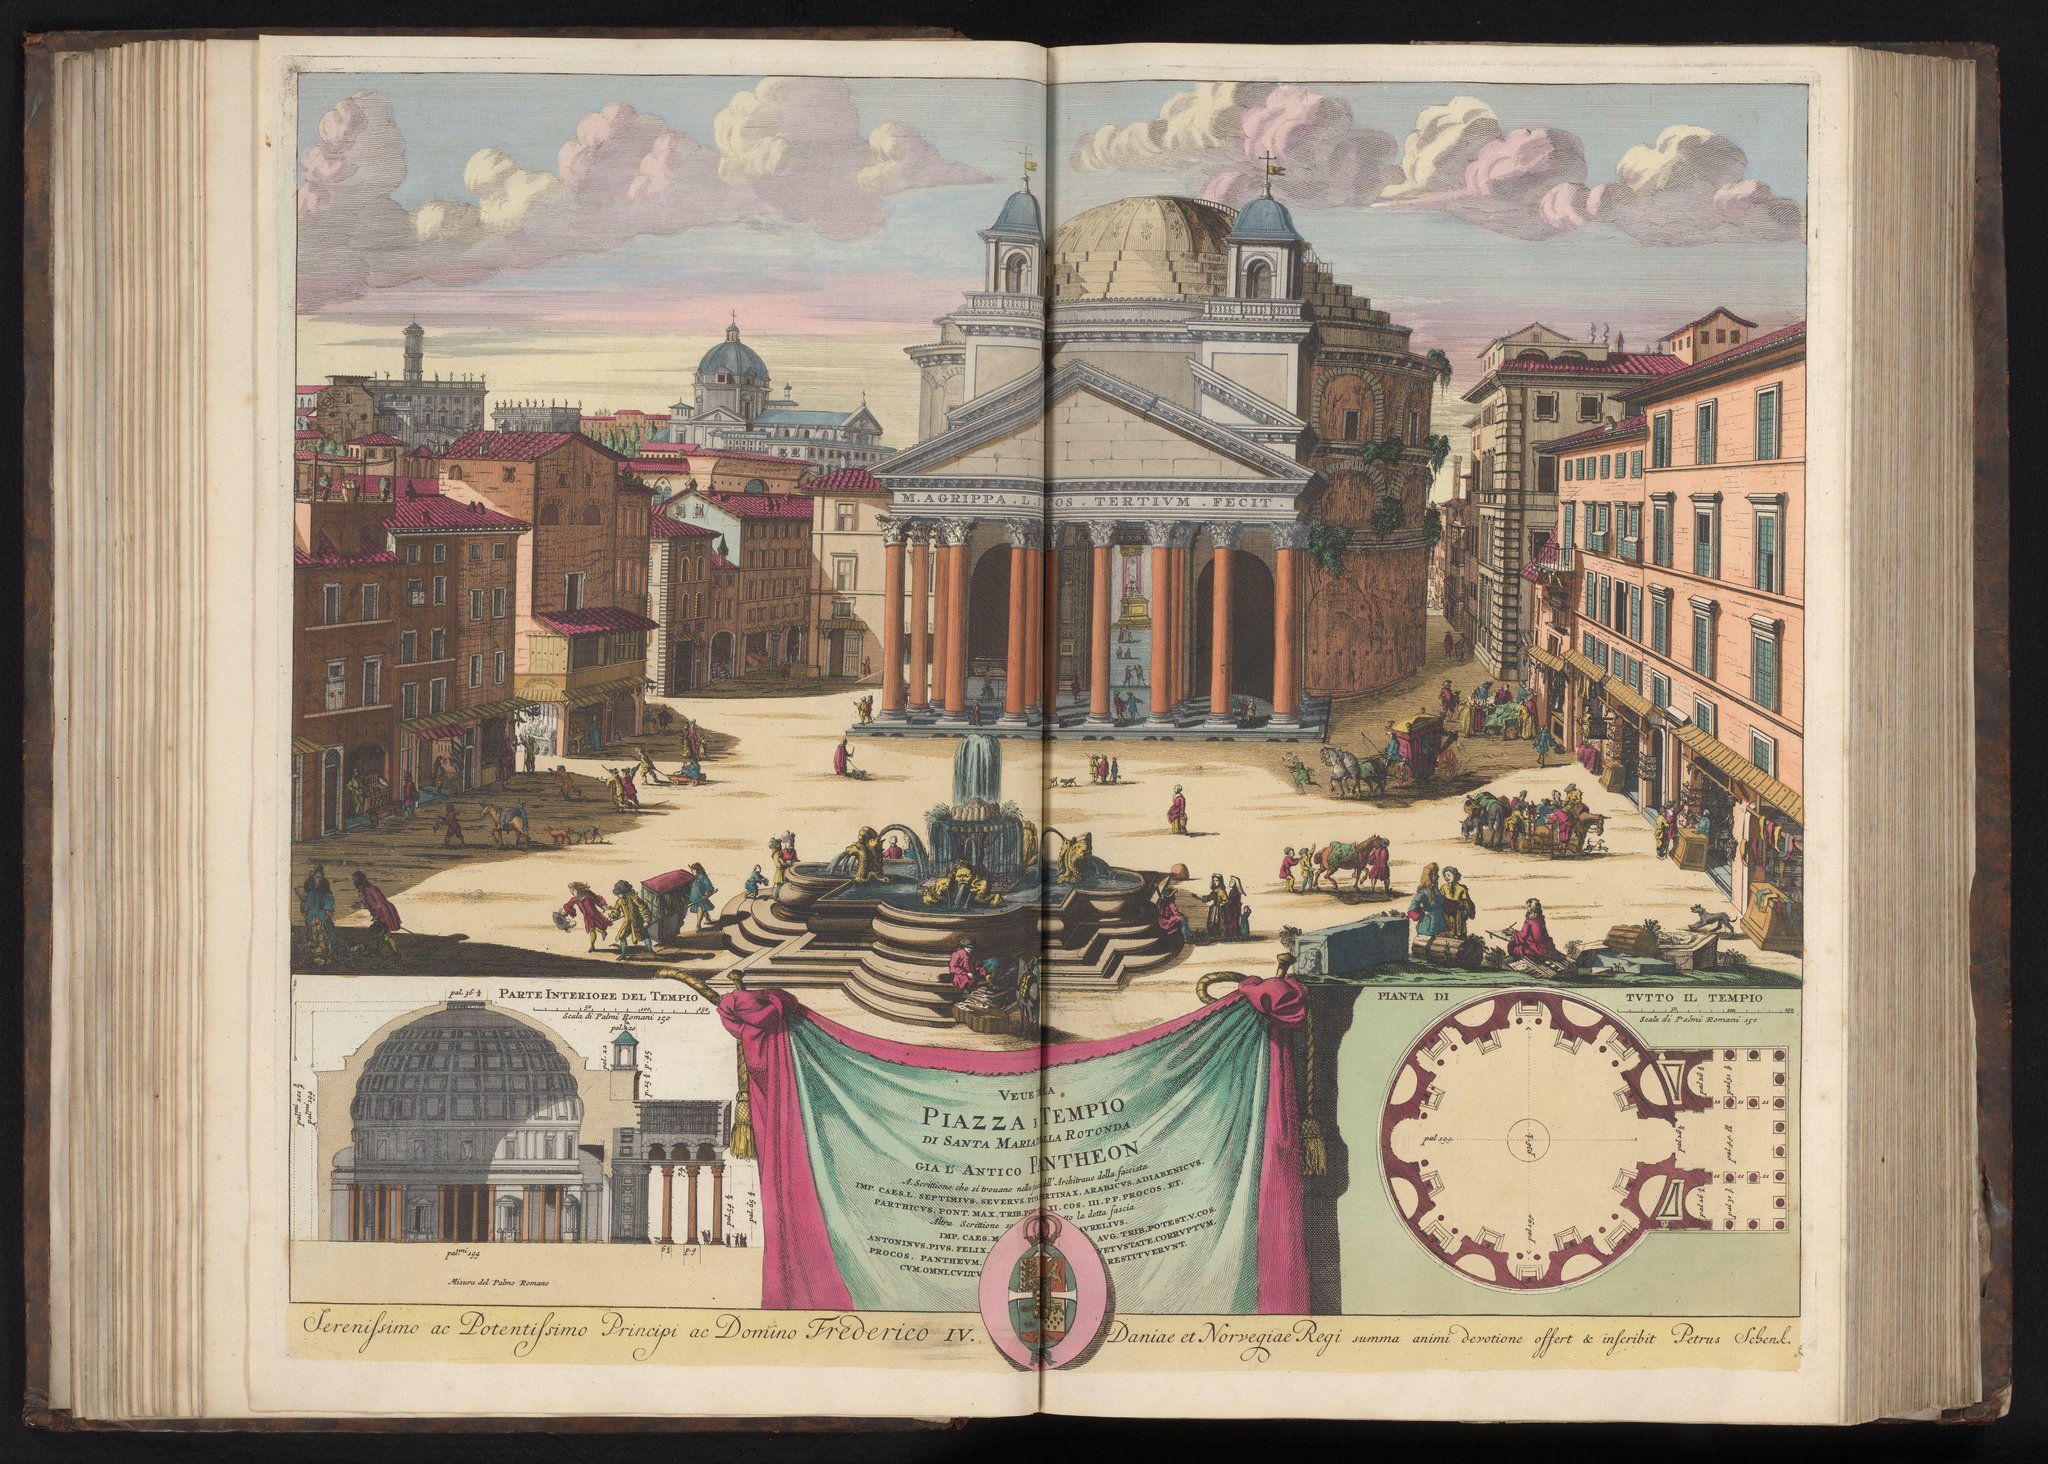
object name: print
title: Pantheon te Rome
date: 1675-1711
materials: paper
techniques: colour, etching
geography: the hague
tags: square, place, circus, etc., church (exterior), temple, shrine ~ roman religion, ornamental fountain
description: Gezicht op het Pantheon aan het Piazza della Rotonda te Rome. Op het plein staat een fontein. Linksonder een verticale doorsnede van het Pantheon, waardoor het interieur zichtbaar wordt. Rechtsonder een plattegrond van het Pantheon. Tussen deze twee kleinere voorstellingen is een doek gespannen met daarop de titel en tekst. In de ondermarge een opdracht in het Latijn. Prent maakt deel uit van een album.